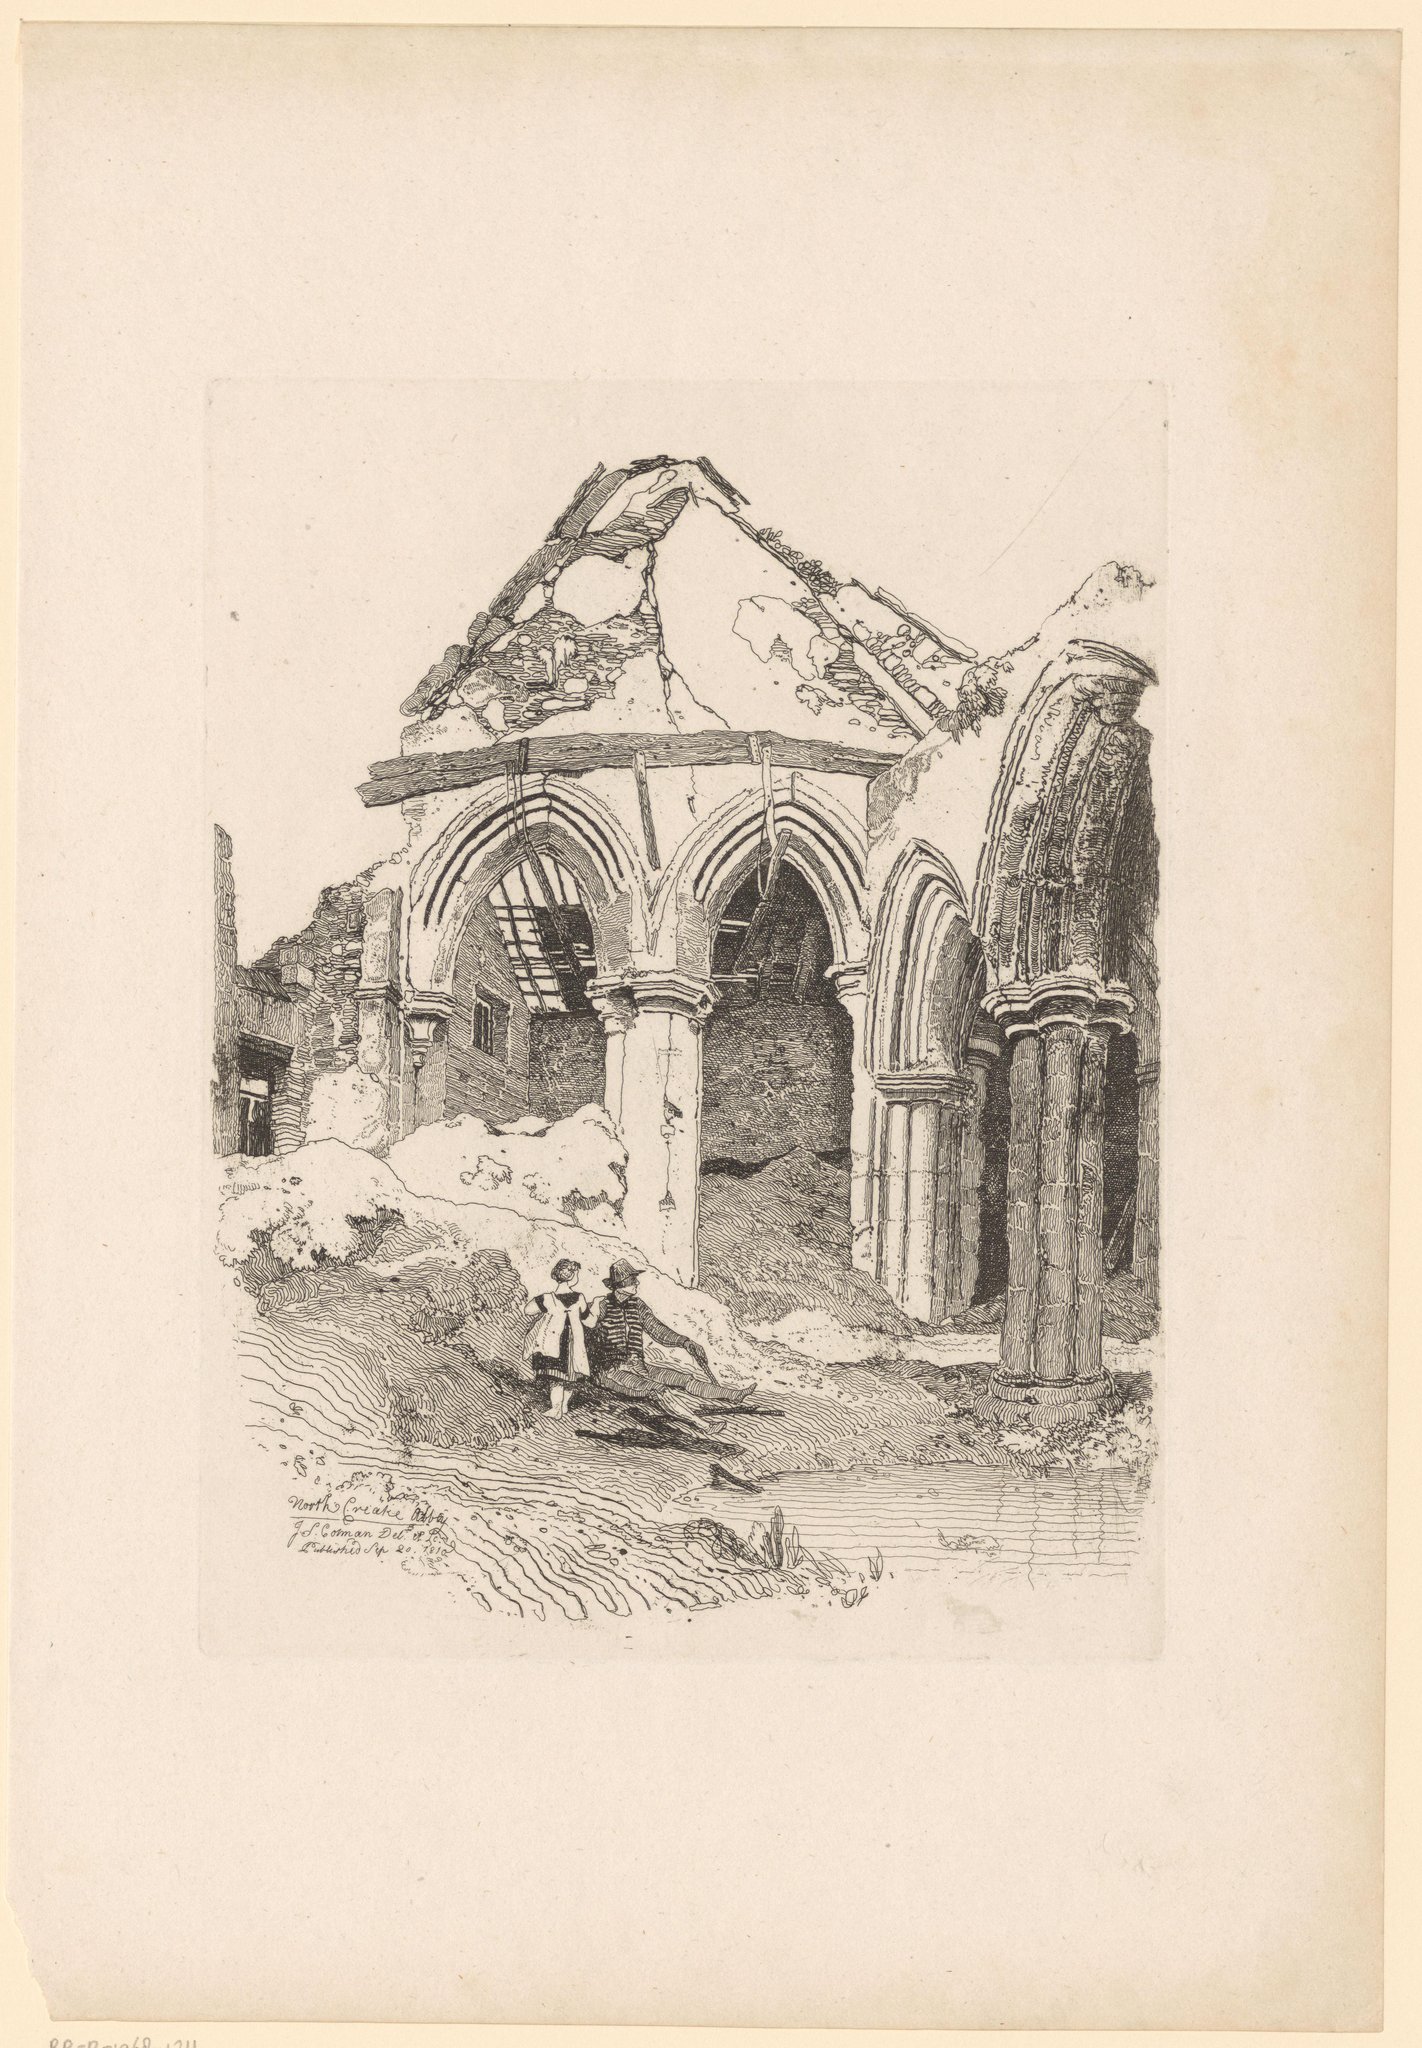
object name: print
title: Etchings by John Sell Cotman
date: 1809-1810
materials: paper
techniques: etching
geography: york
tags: father and daughter(s) (family group), ruin of church, monastery, etc.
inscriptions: collector's mark: Lugt 2228, collector's mark: Lugt 2760